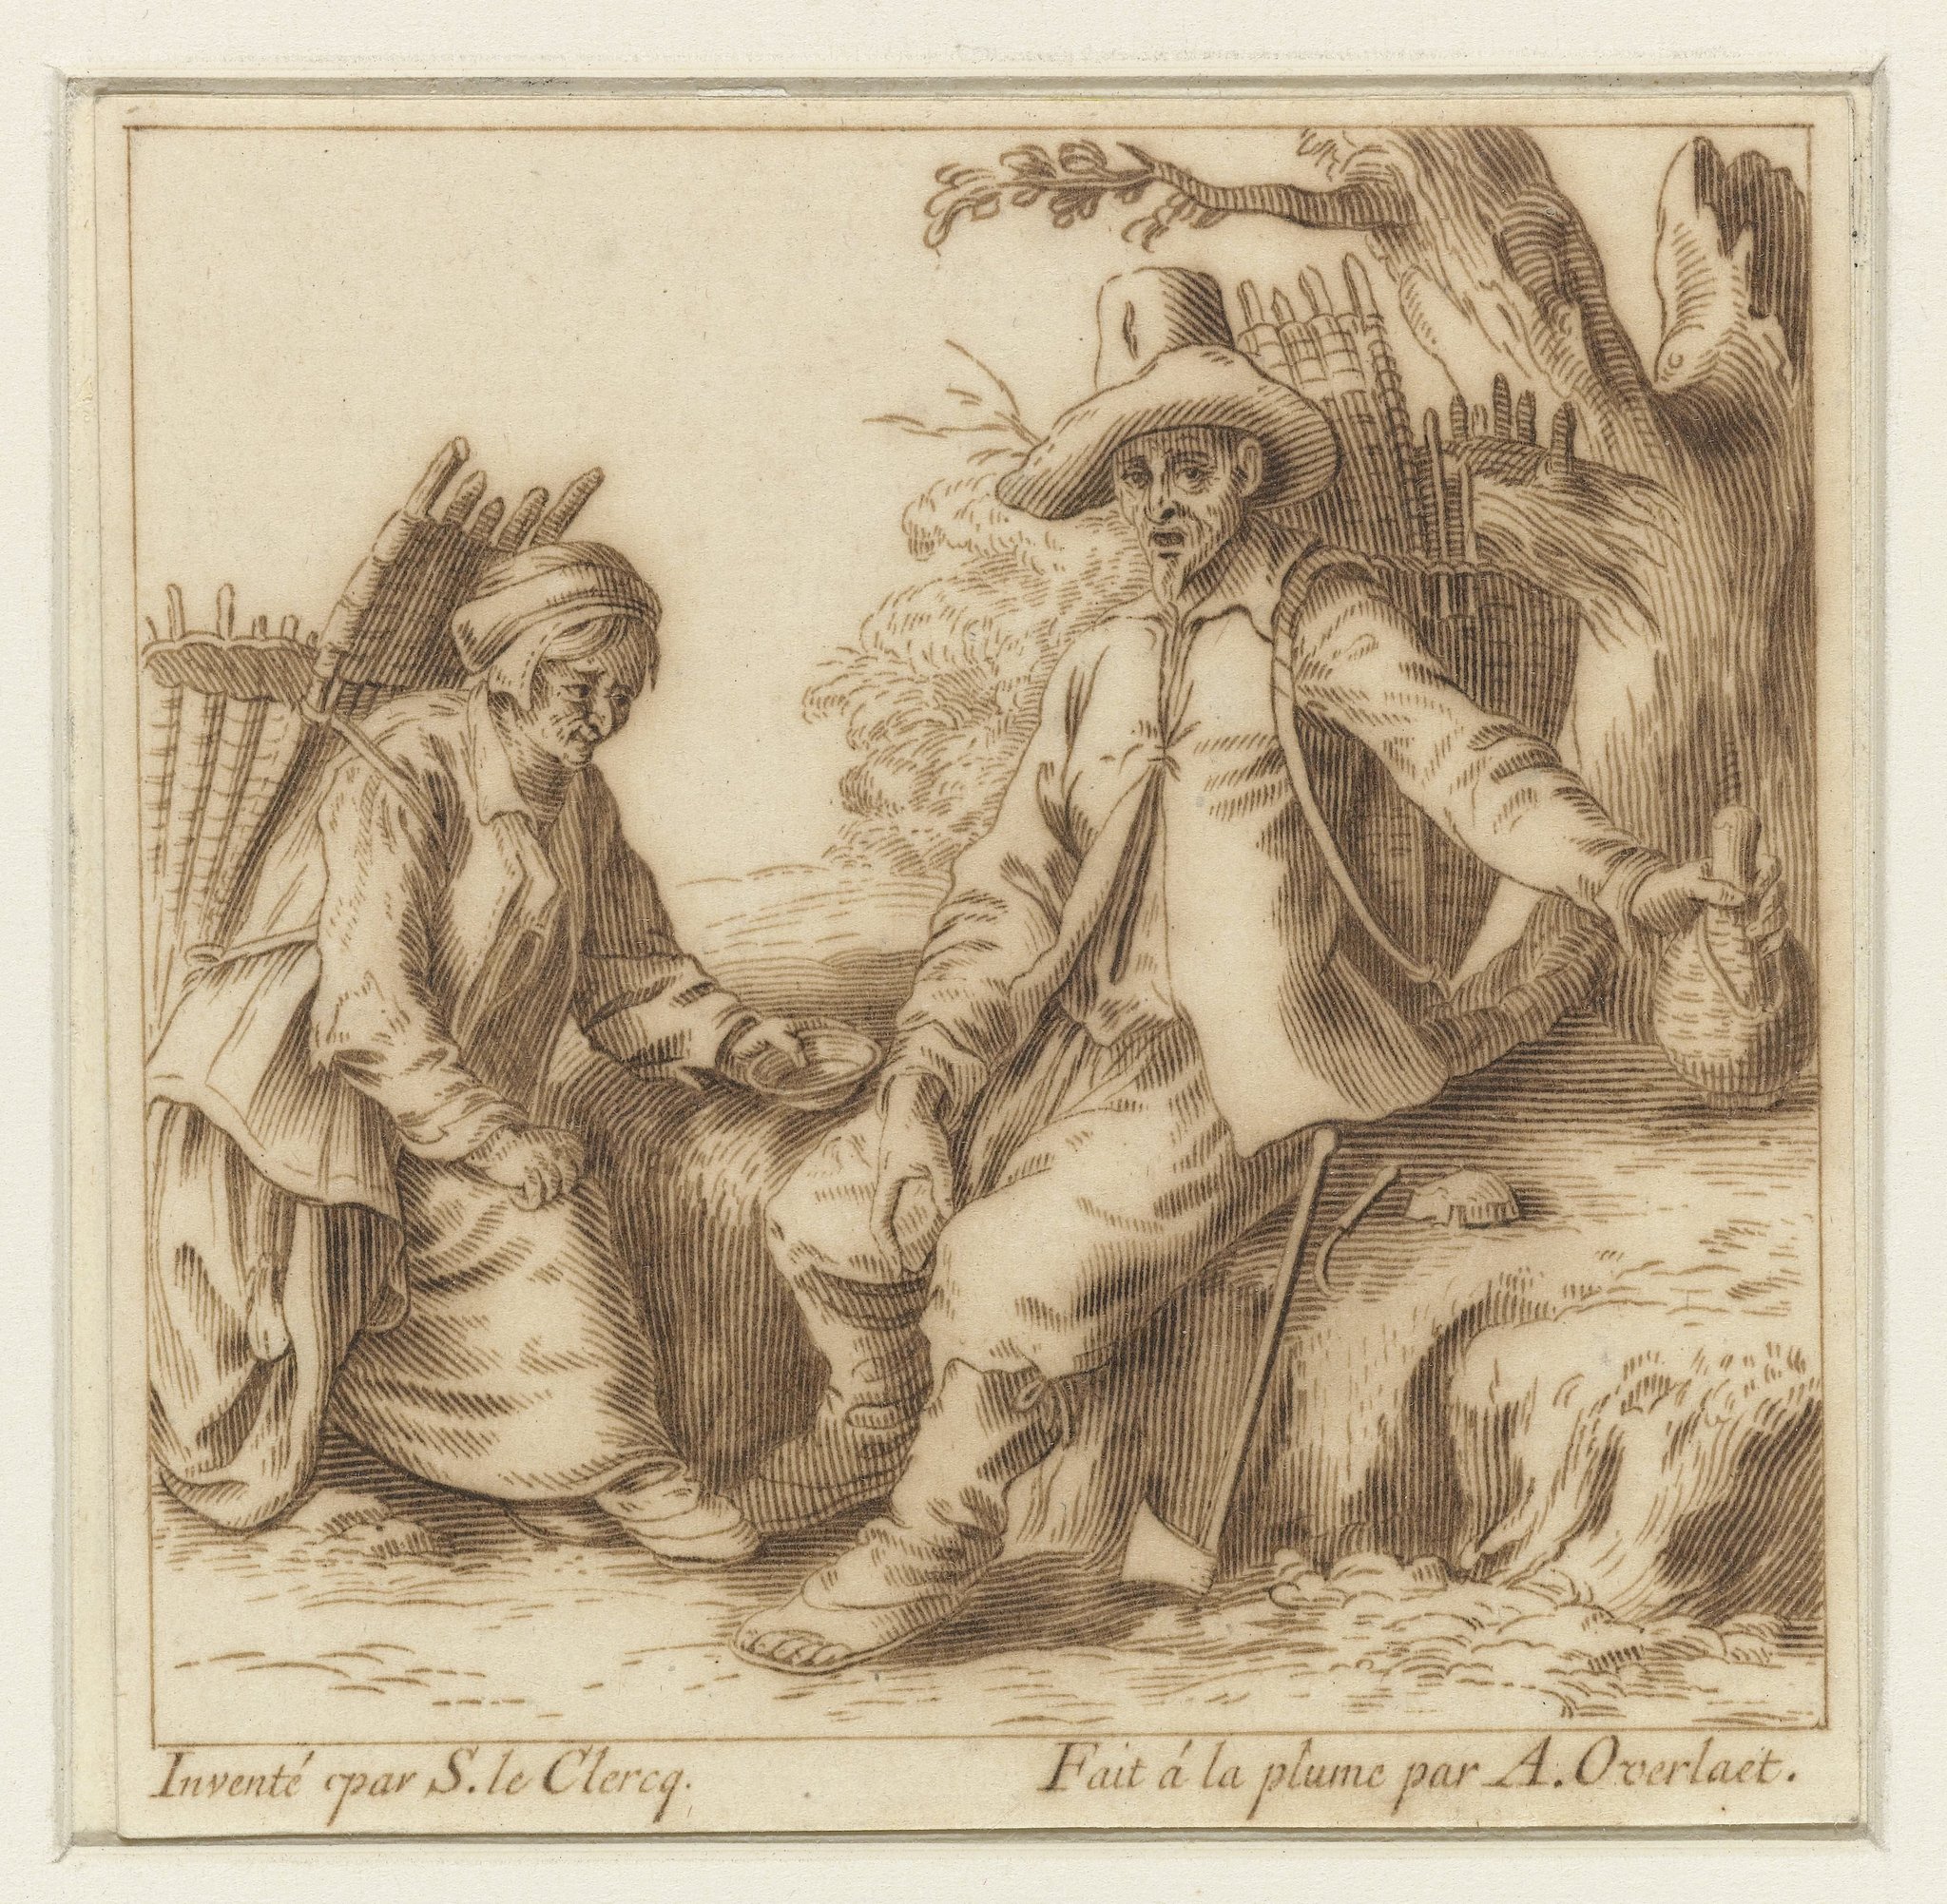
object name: drawing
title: Marskramer en zijn vrouw rustend langs de weg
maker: antoon overlaet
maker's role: draughtsman, print maker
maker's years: 1720-1774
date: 1730-1774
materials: ink, paper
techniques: pen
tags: pedlar, pedlar - bb - women engaged in trade and commerce